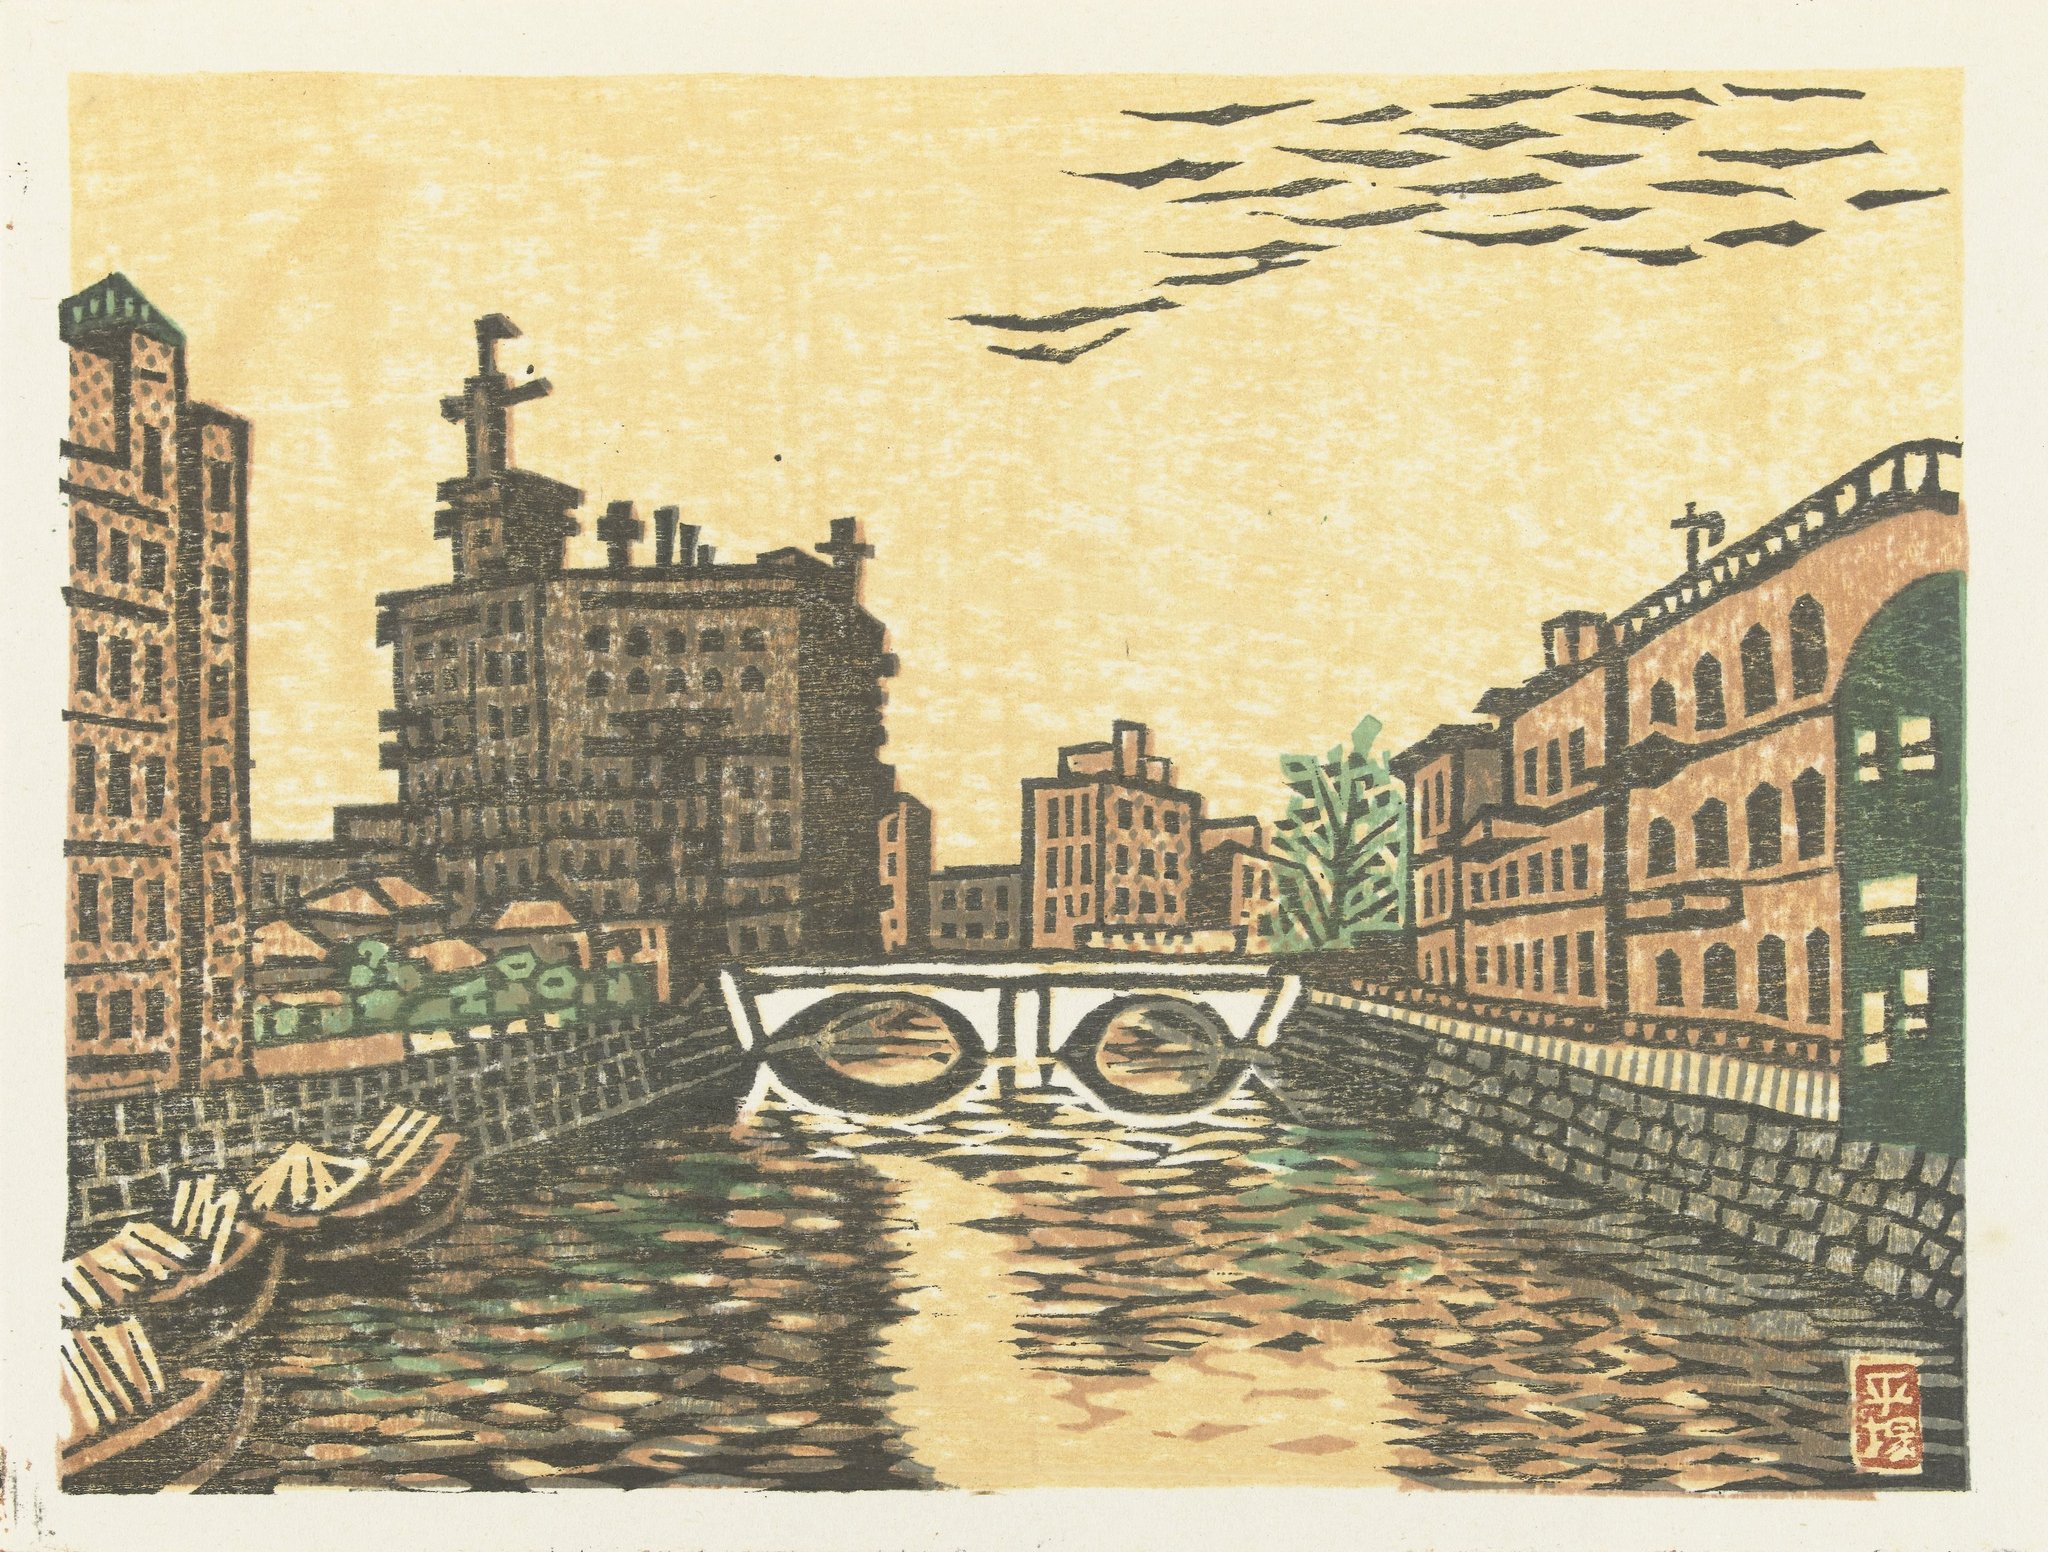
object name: print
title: Sukiya brug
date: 1912-1945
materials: paper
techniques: woodcut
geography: tokyo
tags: bridge in city across river, canal, etc.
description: Gezicht op de rivier met aan weerszijden gebouwen en witte brug op de achtergrond. In origineel passepartout met rechtsonder een wit etiket waarop titel en naam van kunstenaar.